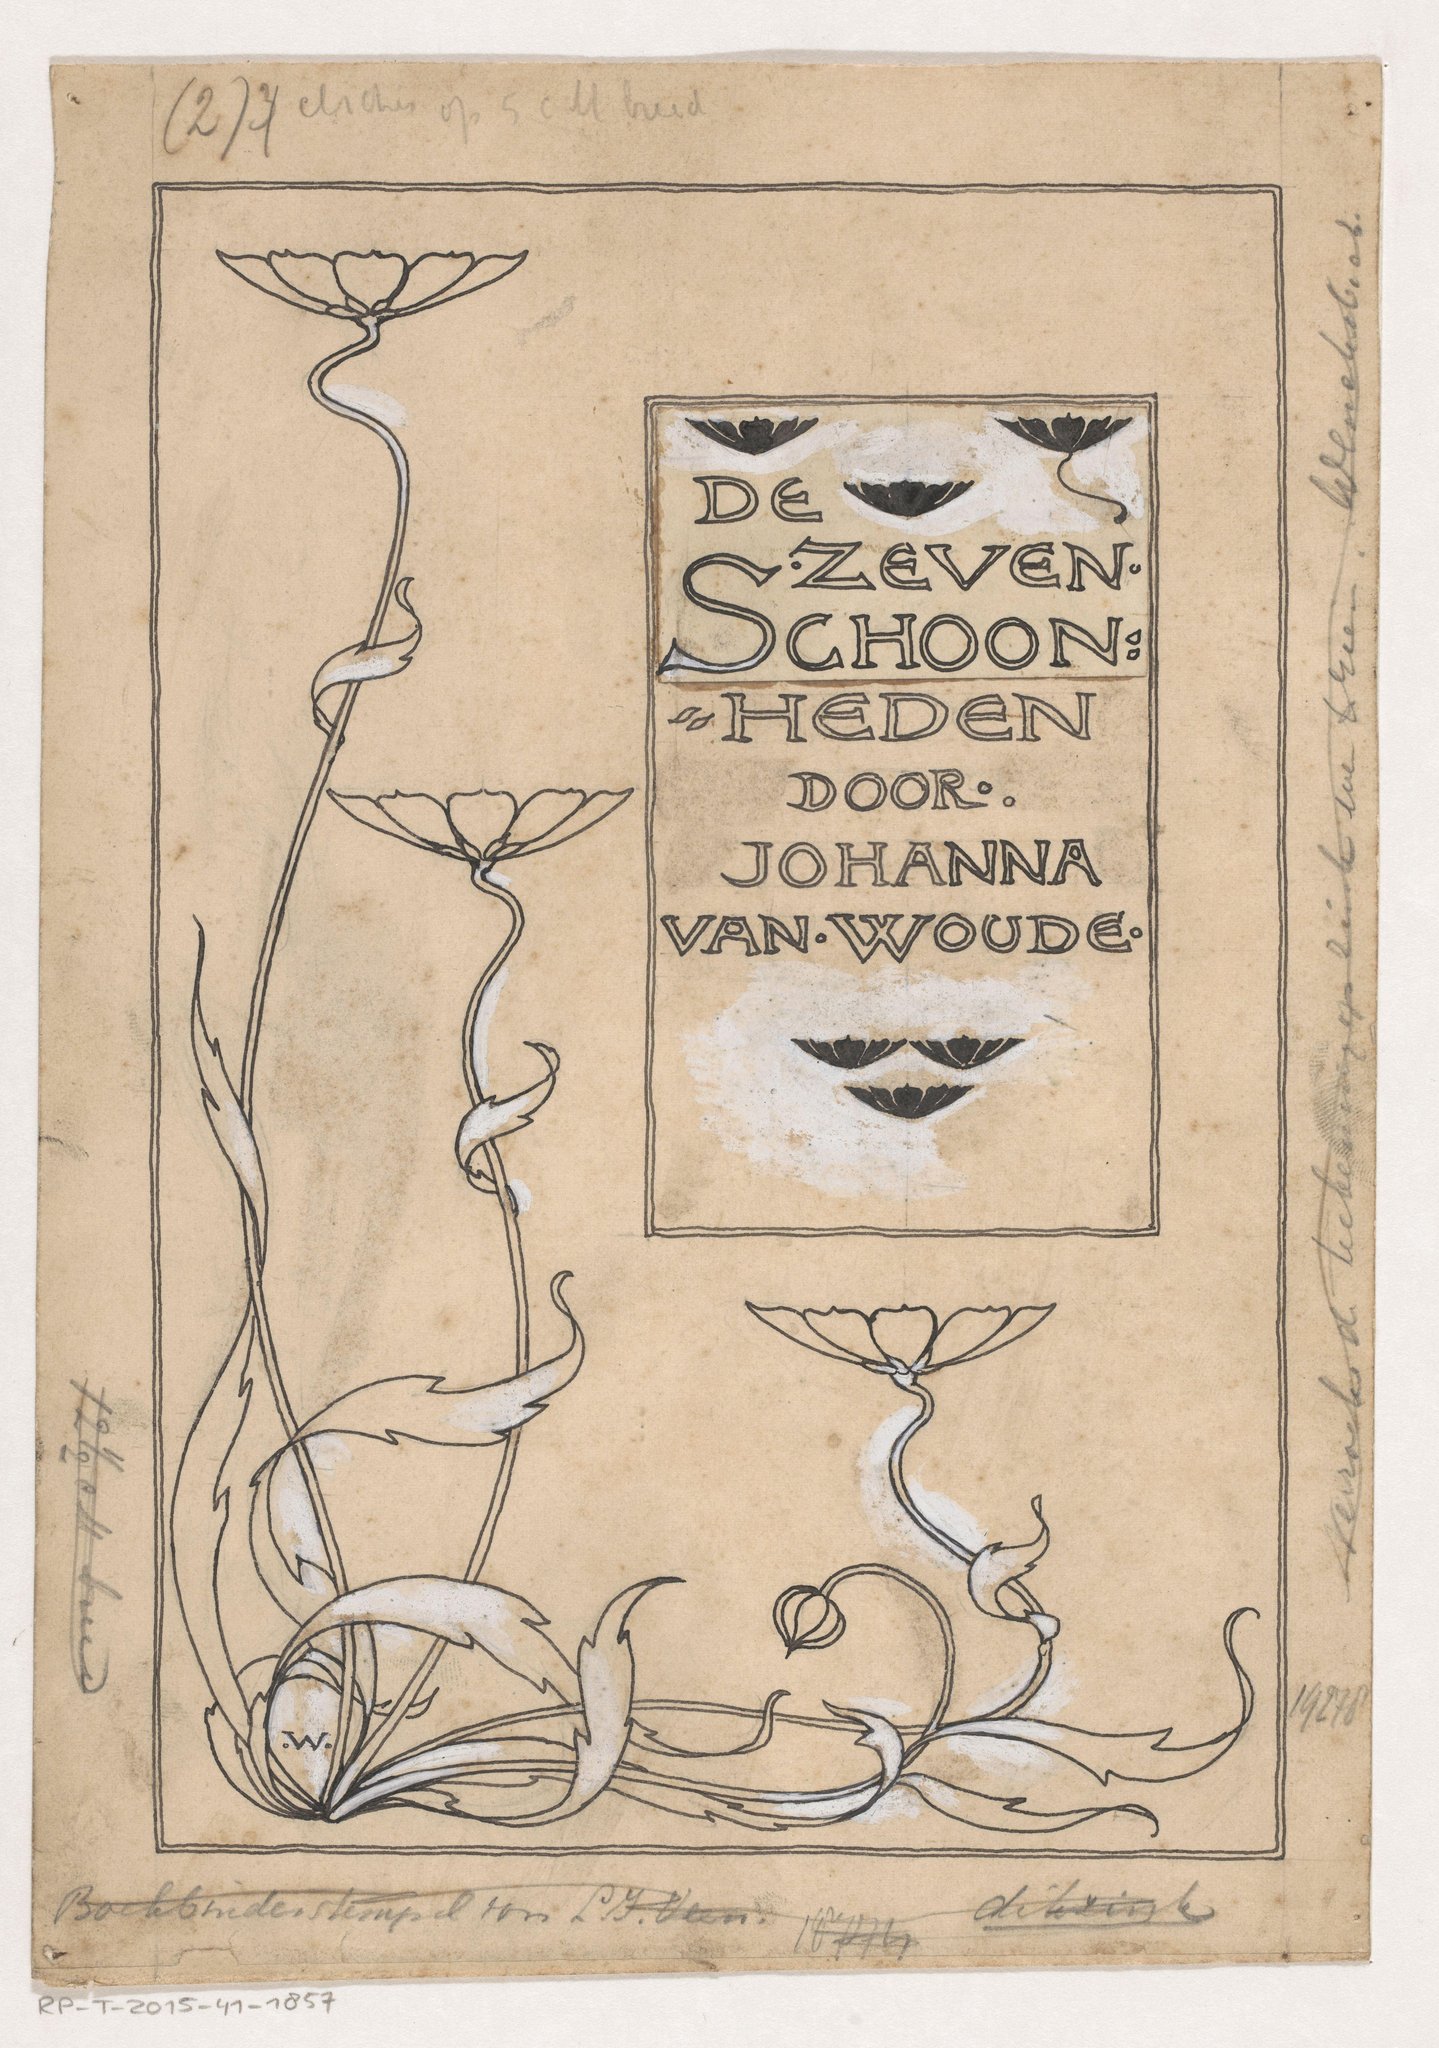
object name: study for binding design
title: Bandontwerp voor: Johanna van Woude, De zeven schoonheden, 1897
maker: willem wenckebach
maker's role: designer, draughtsman, painter, print maker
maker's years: 1860-1937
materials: cardboard, paint, ink, paper, pencil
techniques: brush, pen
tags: flowers ~ ornament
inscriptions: :, monogram: ‘.W.’, collector's mark: Lugt 2228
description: Boektitel en auteursnaam in een rechthoekig kader met zes gestileerde bloemkelken. Rond het kader drie opwaarts groeiende bloemen met bladeren.